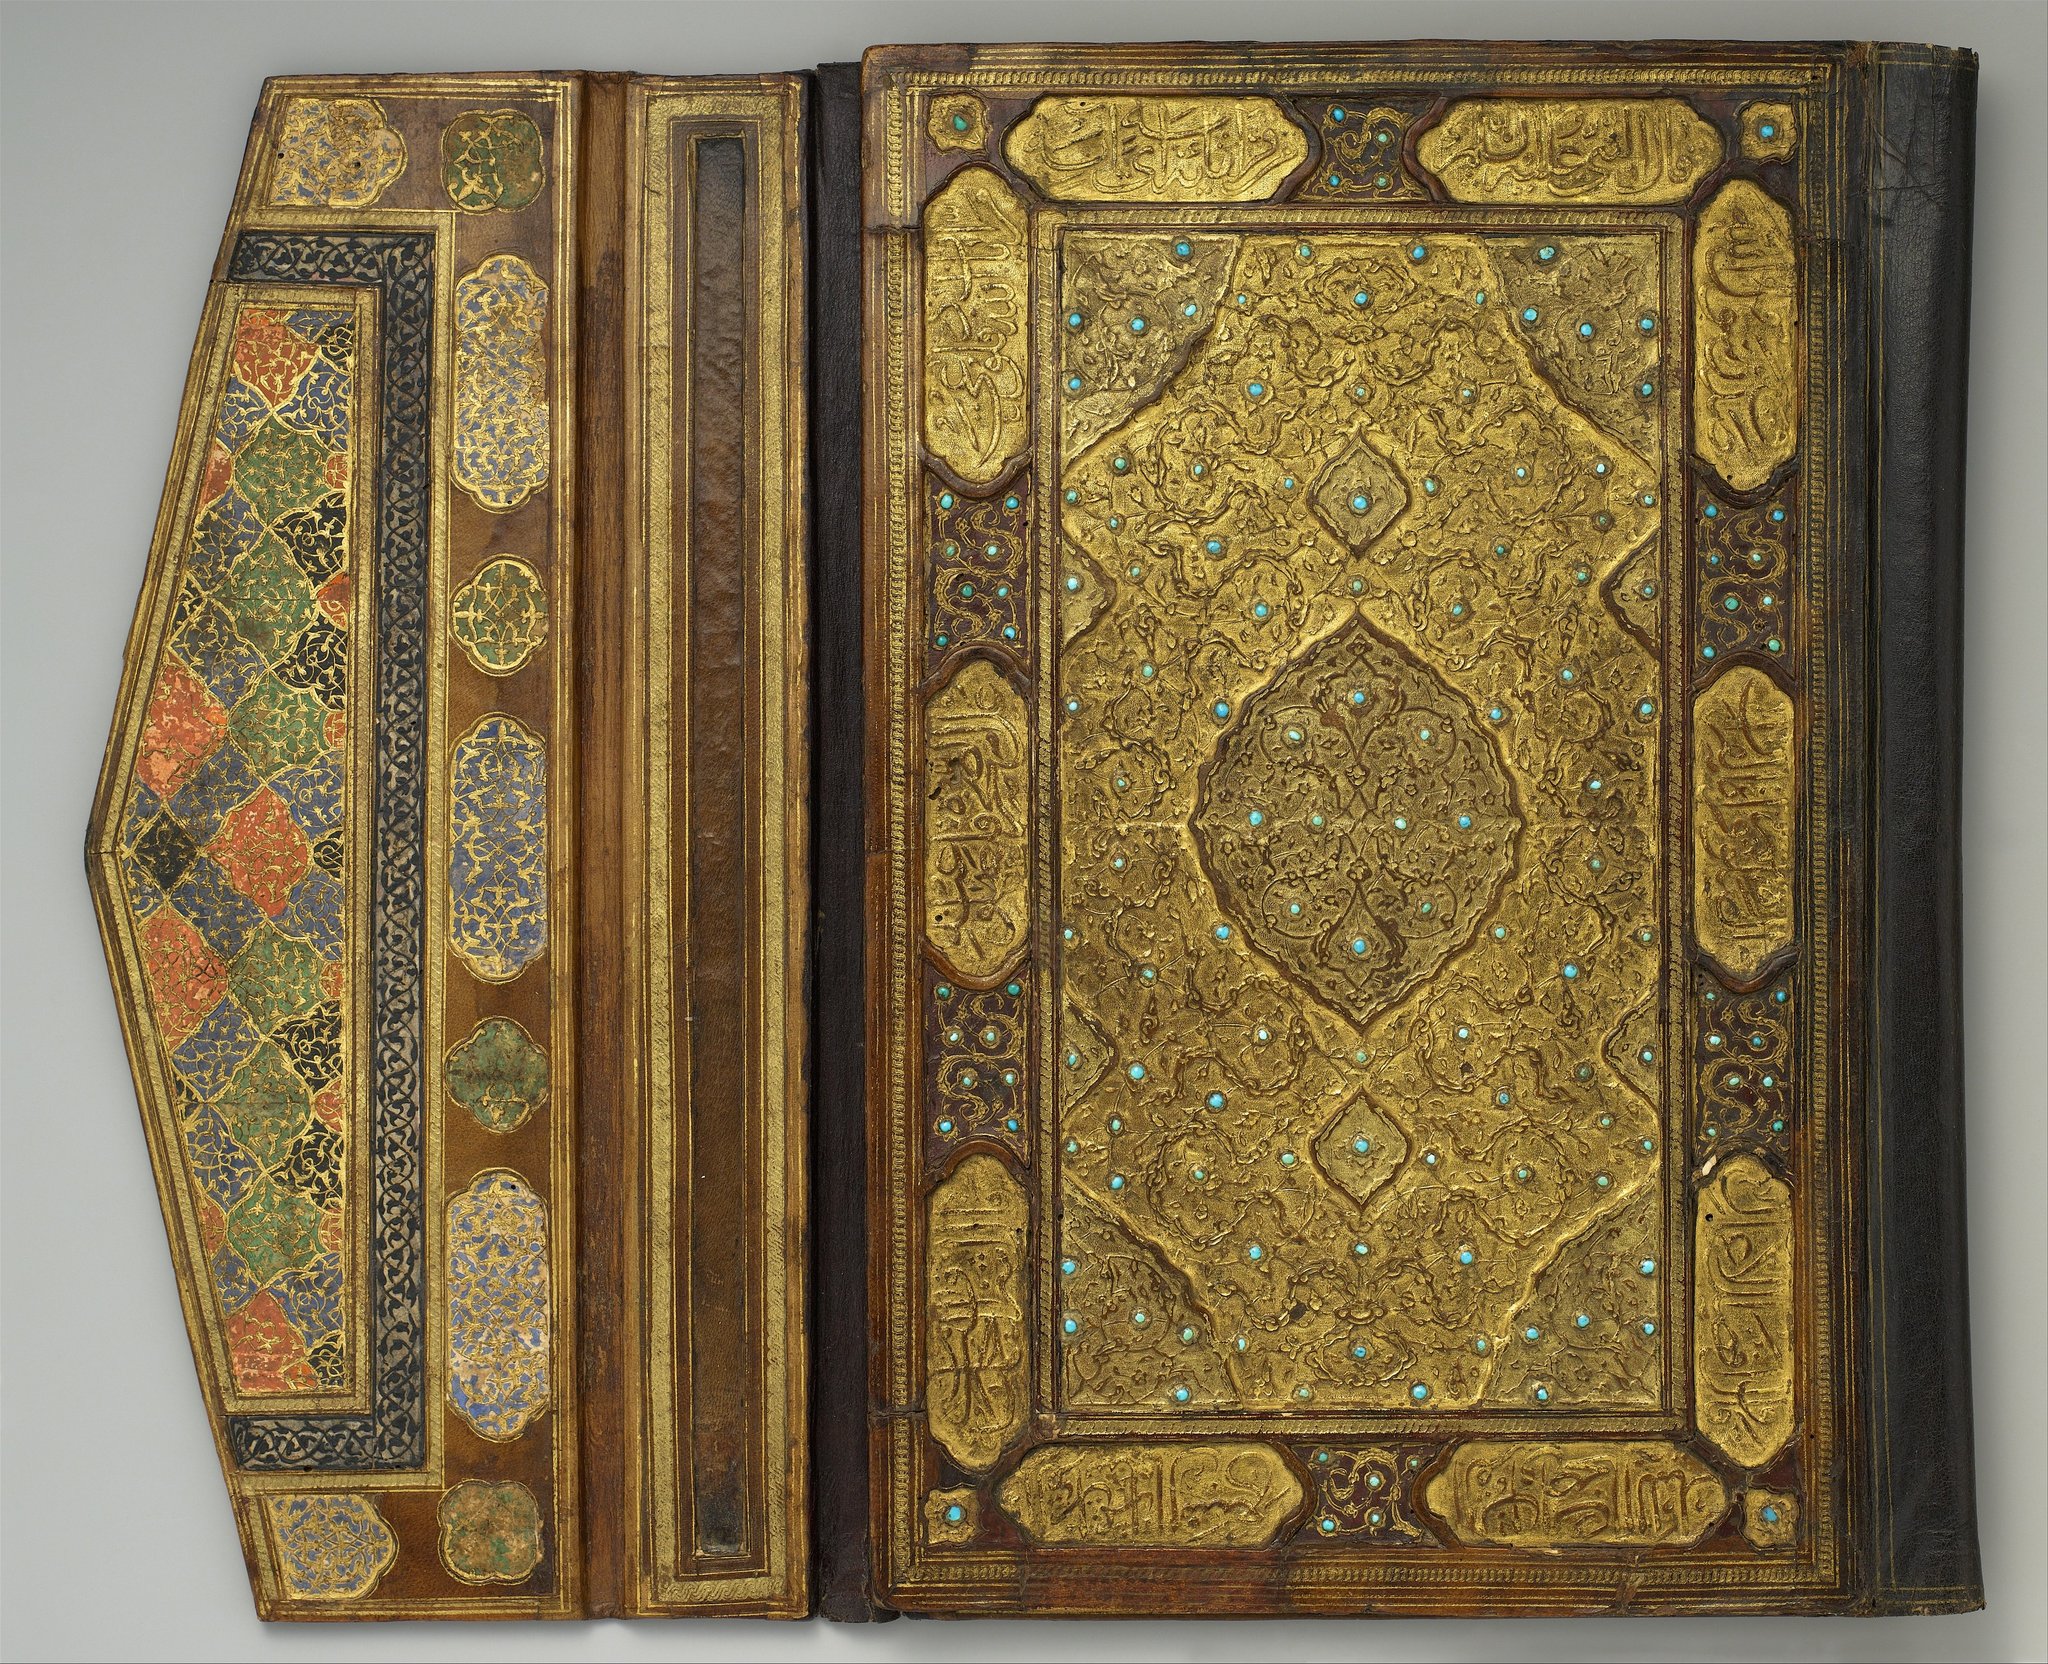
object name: bookbinding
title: Qur'an Bookbinding Inset with Turquoise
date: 1501-1600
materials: leather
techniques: gilding, painting, stamping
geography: iran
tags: arabic